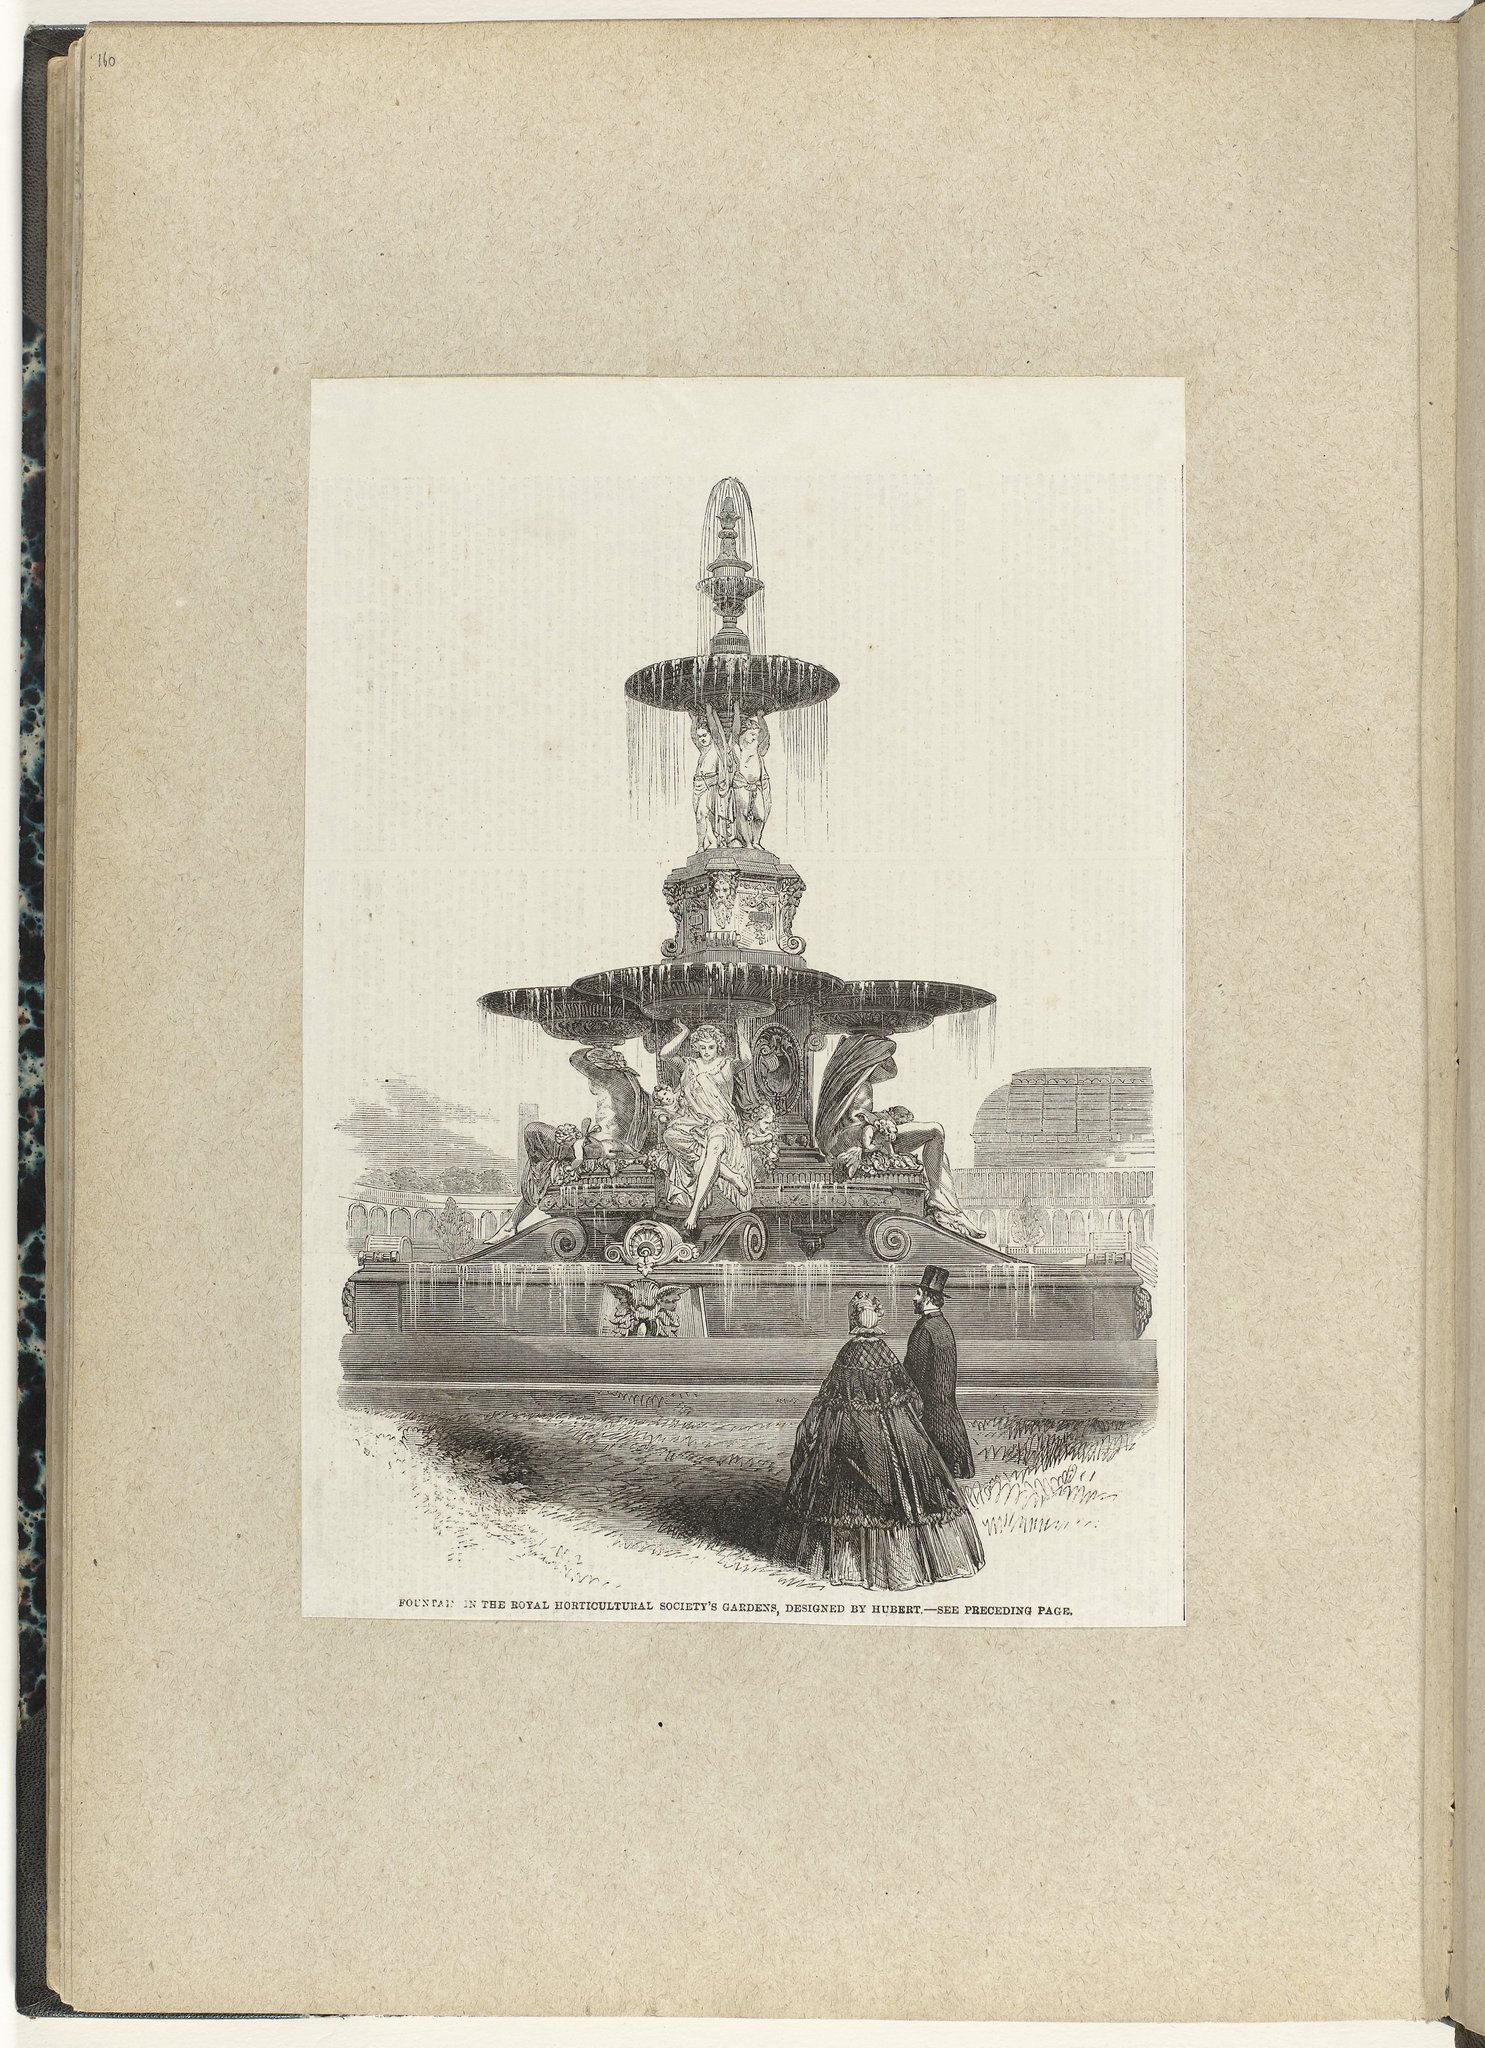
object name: print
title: Fountain in the Royal Horticultural Society's gardens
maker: Anonymous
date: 1866-1900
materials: paper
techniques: engraving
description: Het bassin bovenaan wordt gedragen door putti, rechtsonder lopen een man en een vrouw. De fontein is ontworpen door Hubert.